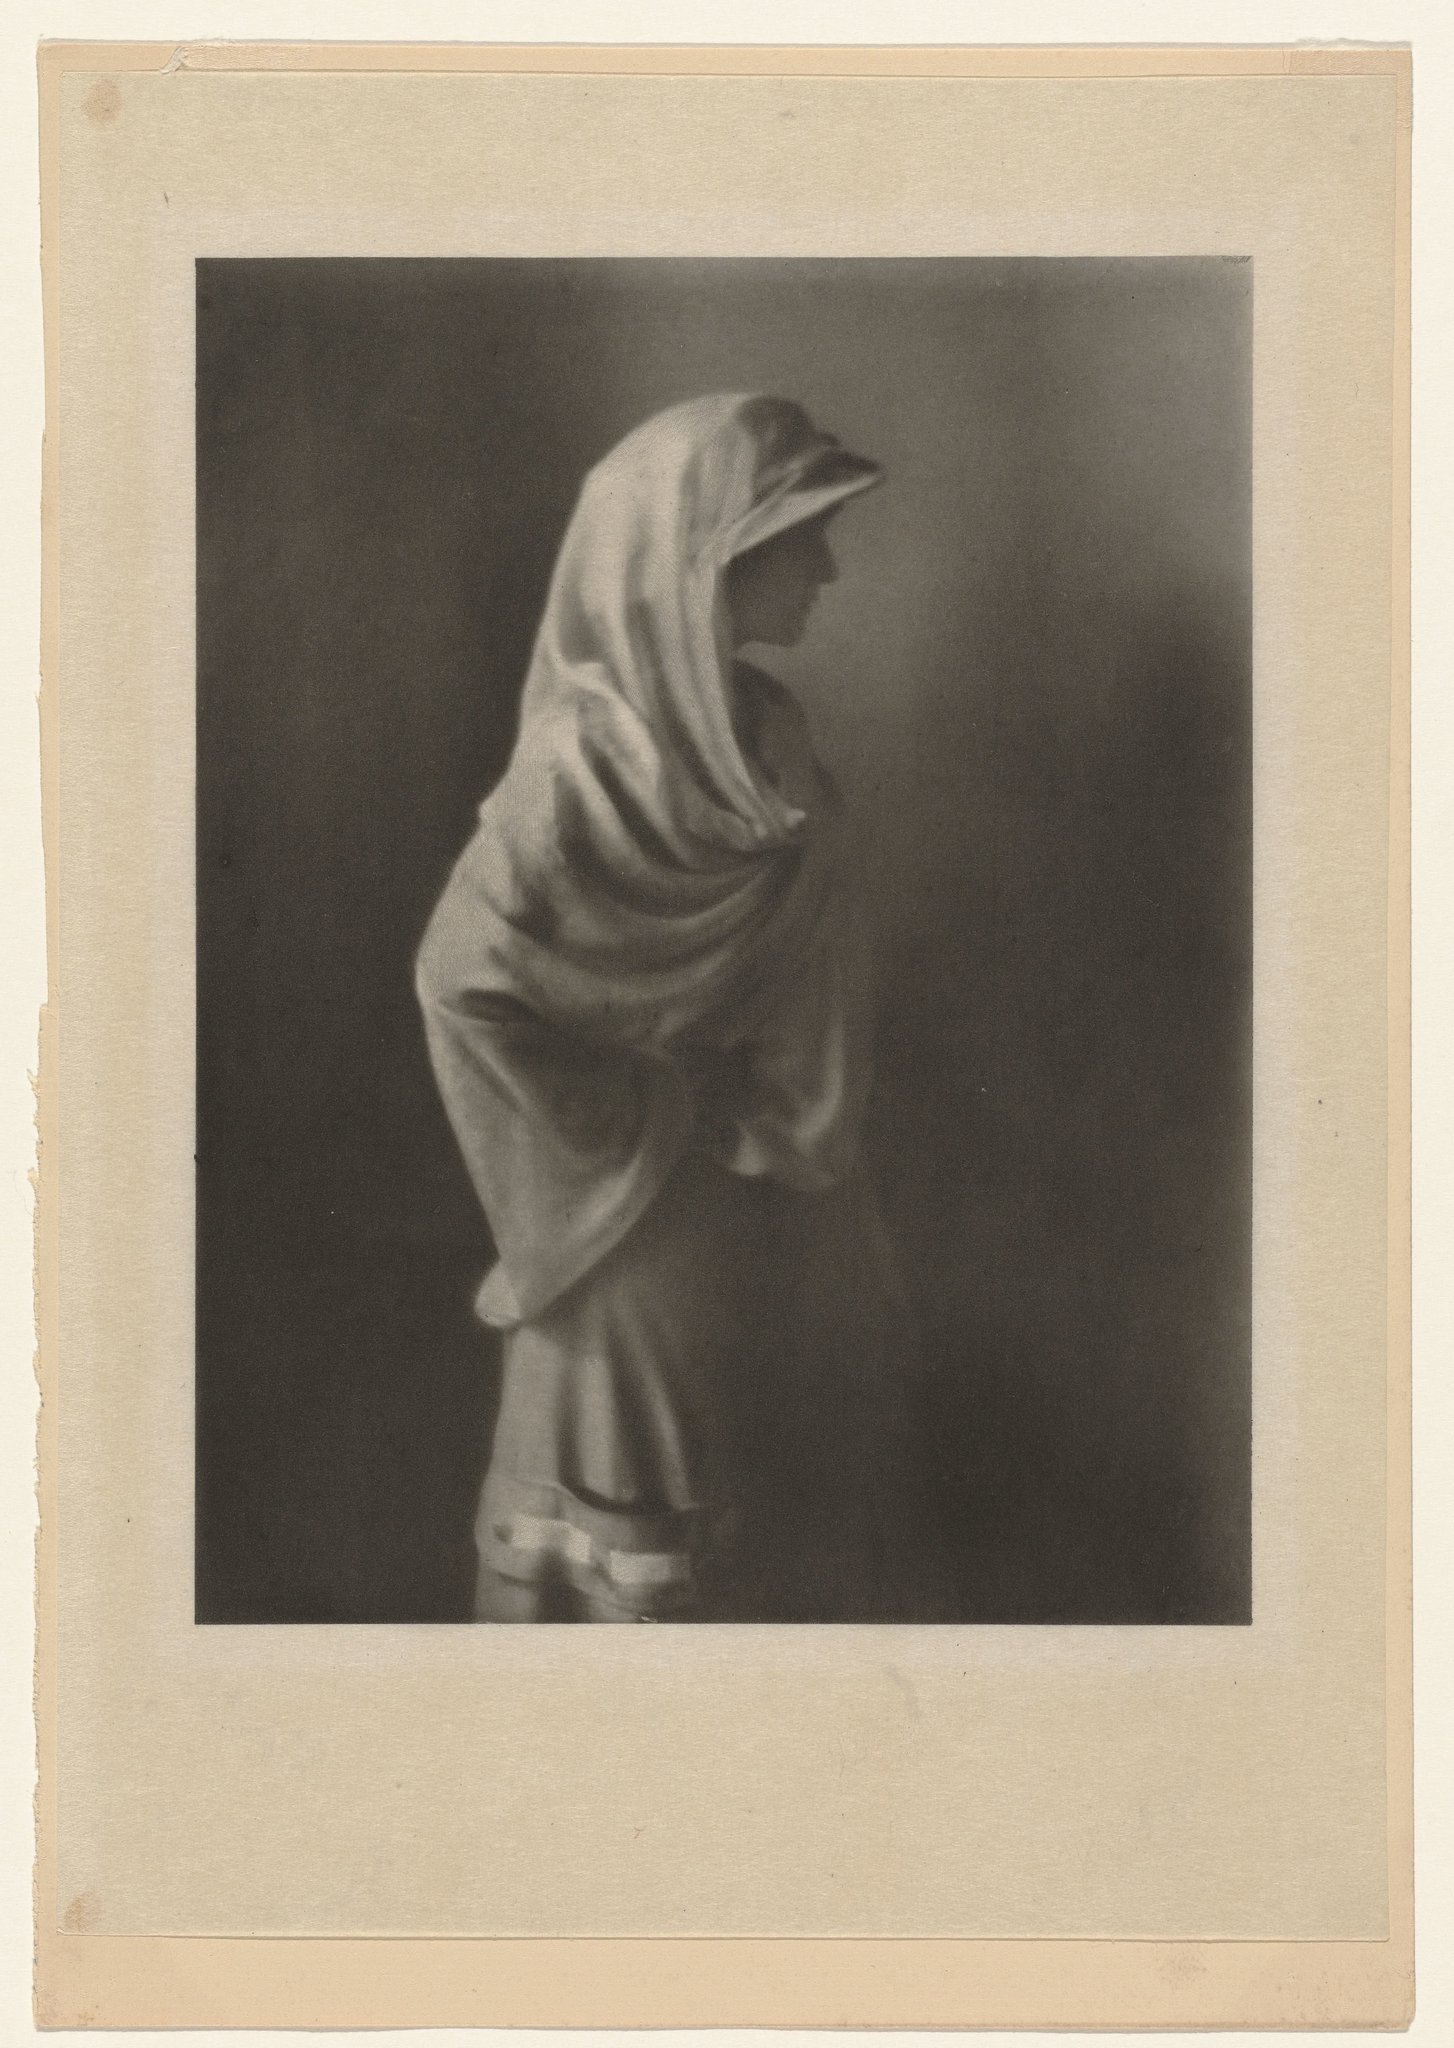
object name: photomechanical print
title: Portret van Doris Keane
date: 1912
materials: ink, paper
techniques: photoaquatint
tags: portrait of actor, actress